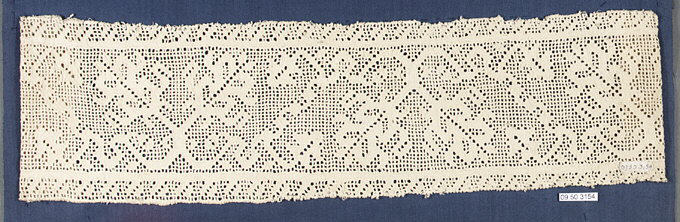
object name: border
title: Border fragment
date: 1501-1700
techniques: embroidery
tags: leaves